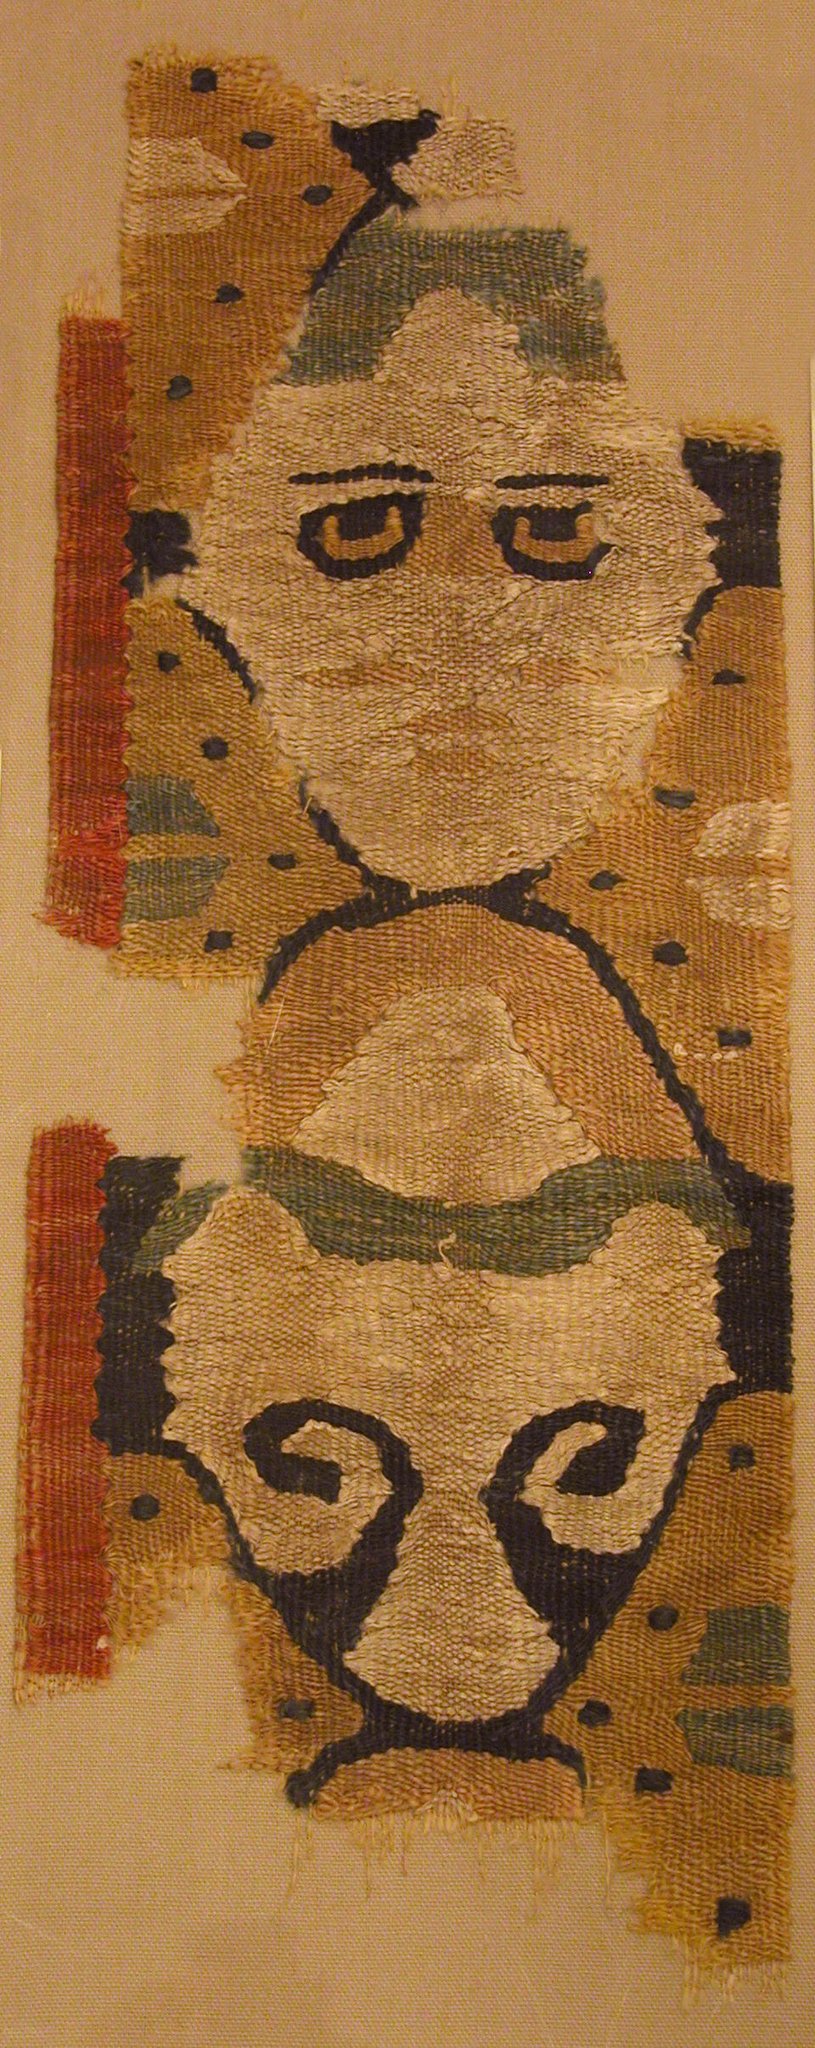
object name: fragment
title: Textile Fragment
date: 801-1000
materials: linen, wool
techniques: weave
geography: egypt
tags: faces